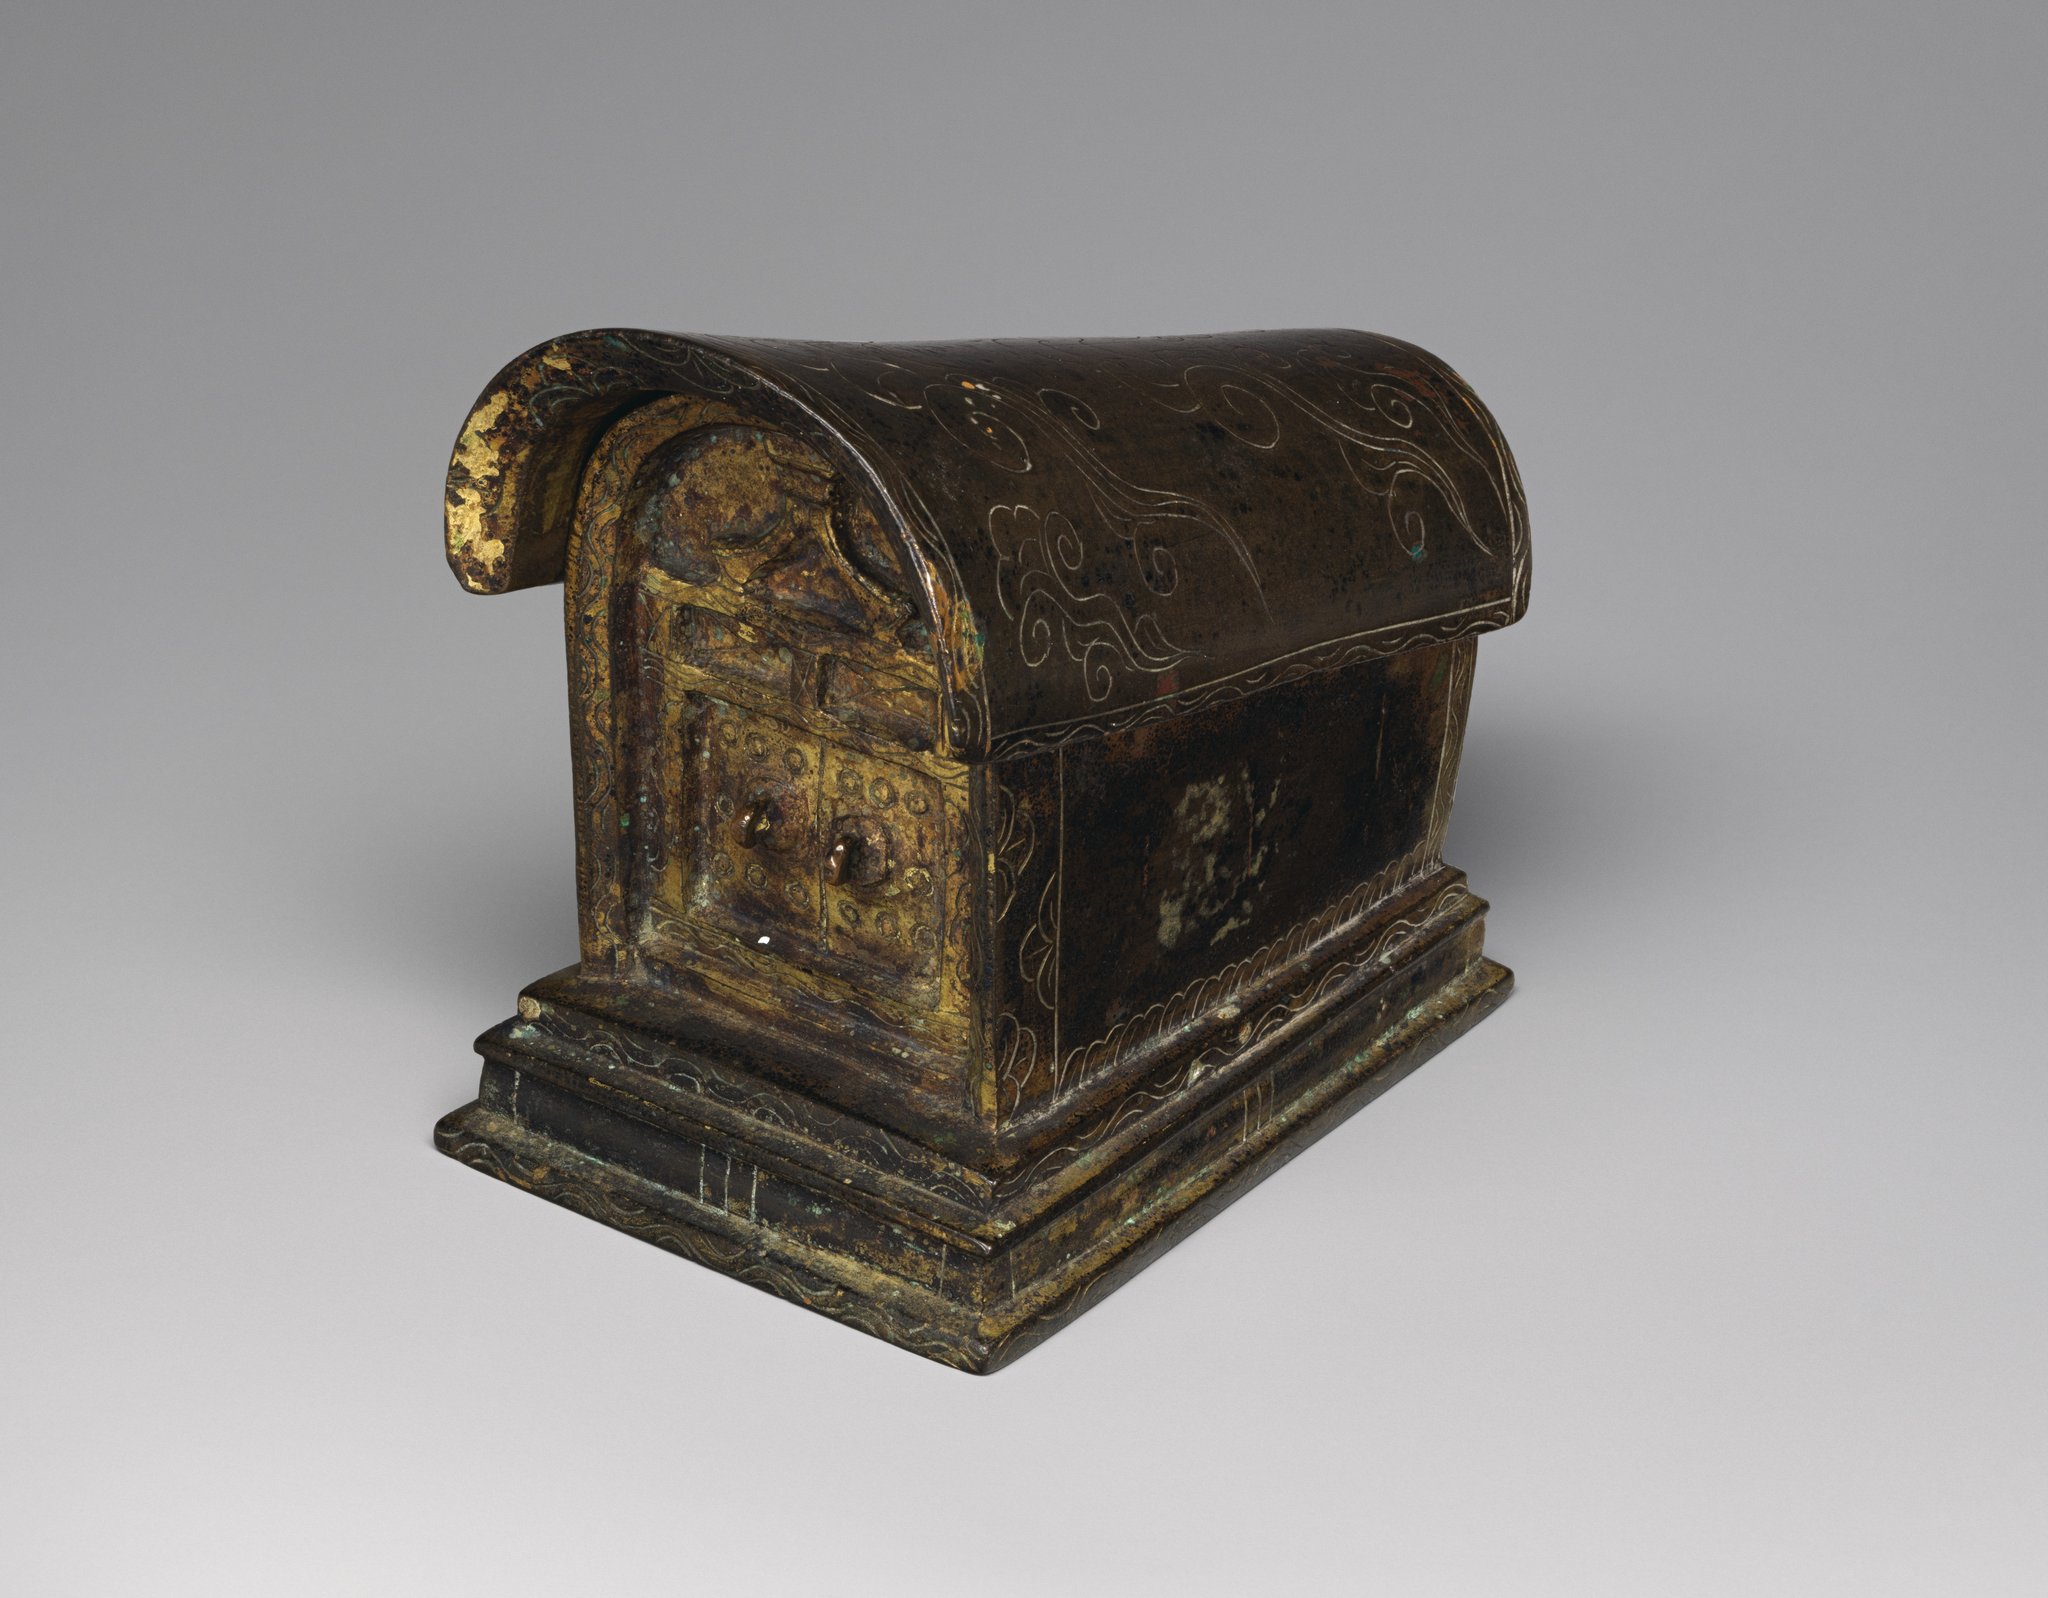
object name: reliquary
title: Reliquary in the shape of a coffin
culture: chinese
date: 701-800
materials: gilt bronze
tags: reliquaries